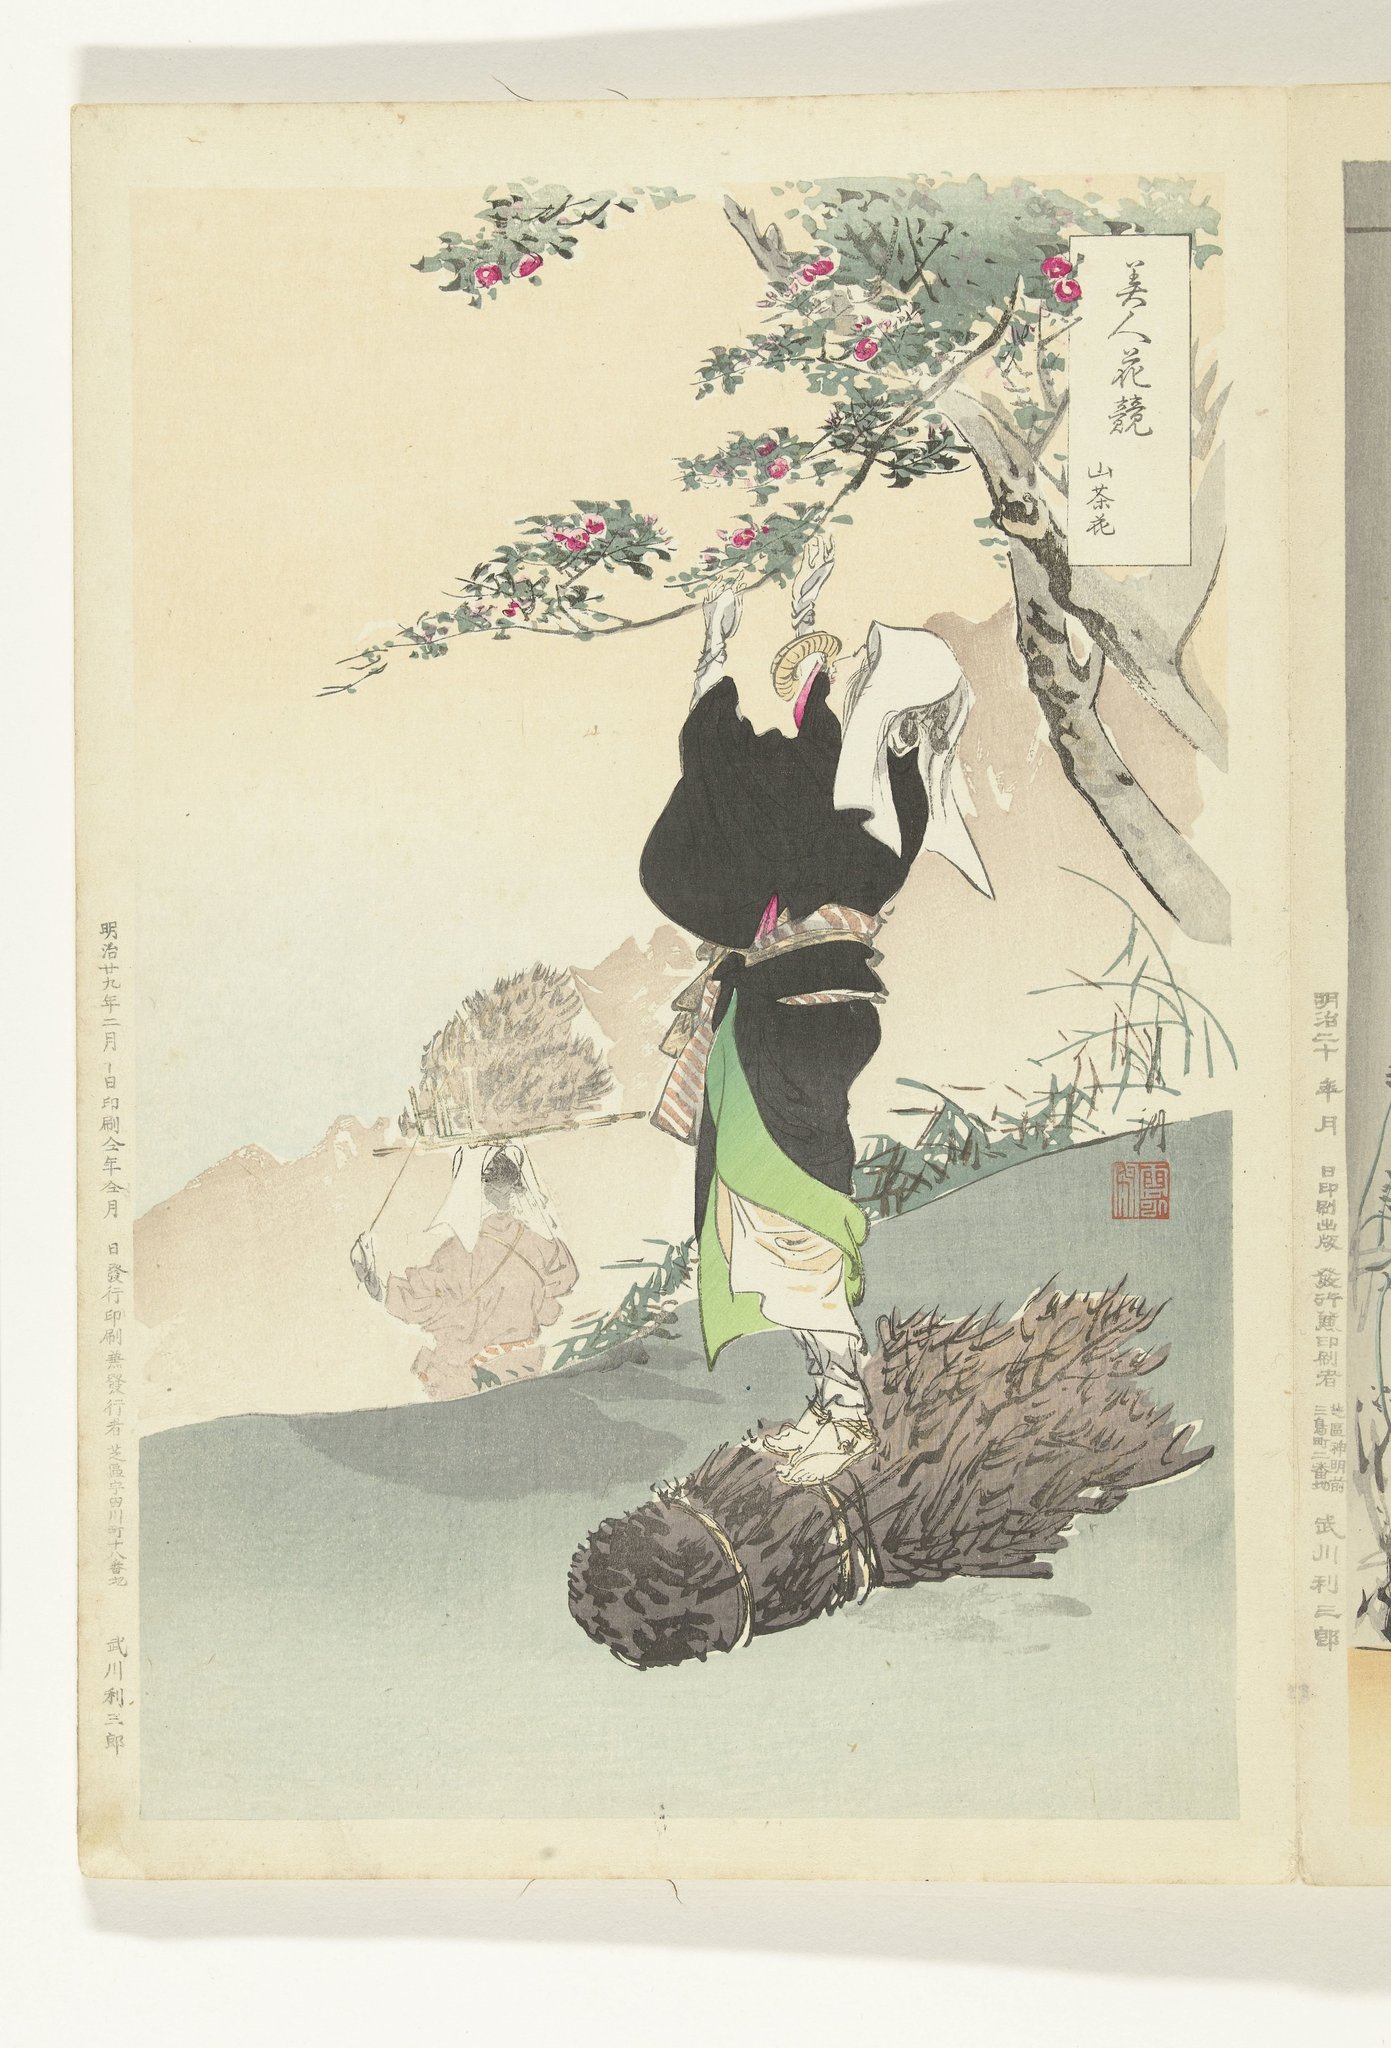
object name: print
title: Vergelijkingen tussen schoonheden en bloemen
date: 1896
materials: paper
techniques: blind stamped, woodcut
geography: japan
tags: reaching for something - aa - female human figure, picking fruit, landscapes (+ landscape with figures, staffage)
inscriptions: collector's mark: Lugt 2228, collector's mark: Lugt 2760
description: Vrouw staand op takkenbos, een bloesemende tak vastpakkend.